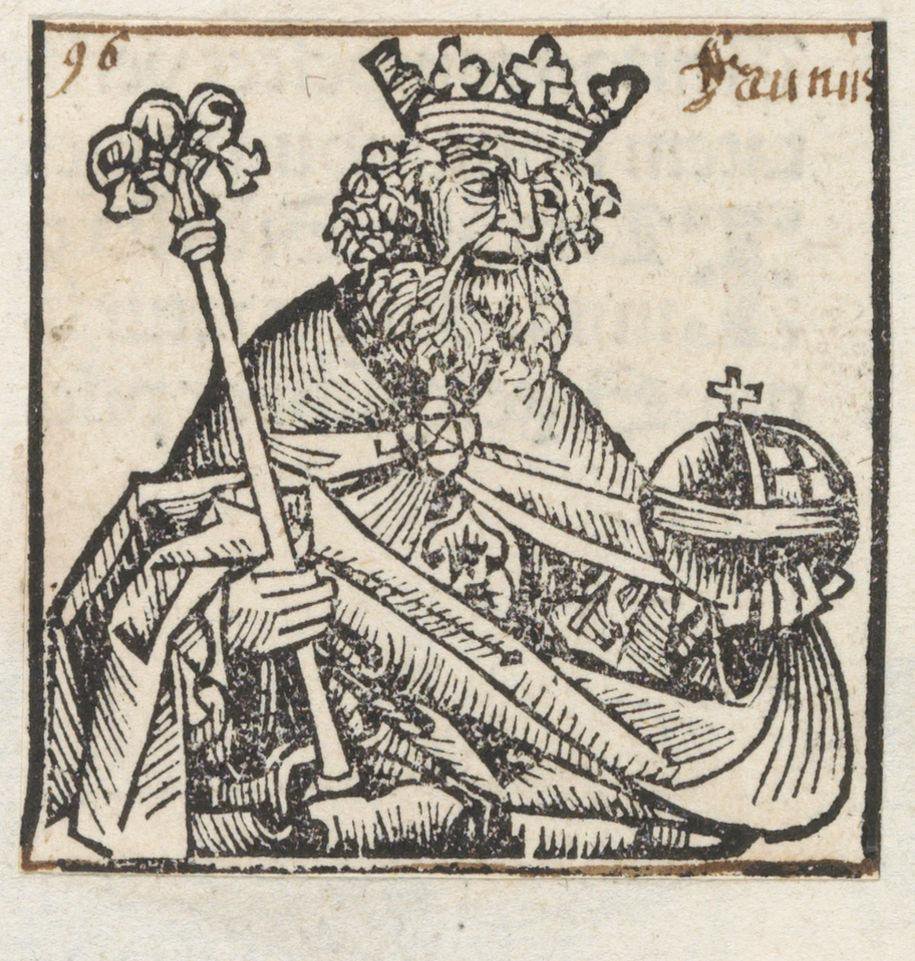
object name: album leaf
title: Faunus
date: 1493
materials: paper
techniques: letterpress printing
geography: nuremberg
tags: king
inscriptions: inscription: ‘96’, inscription: ‘Faunus’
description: Een bloemkelk met een koning. Hij heeft een scepter en een rijksappel in zijn handen. De voorstelling maakt deel uit van de opeenvolging van Italiaanse koning in de Liber Chronicarum. De tekst identificeert de man als Faunus. De prent maakt deel uit van een album.